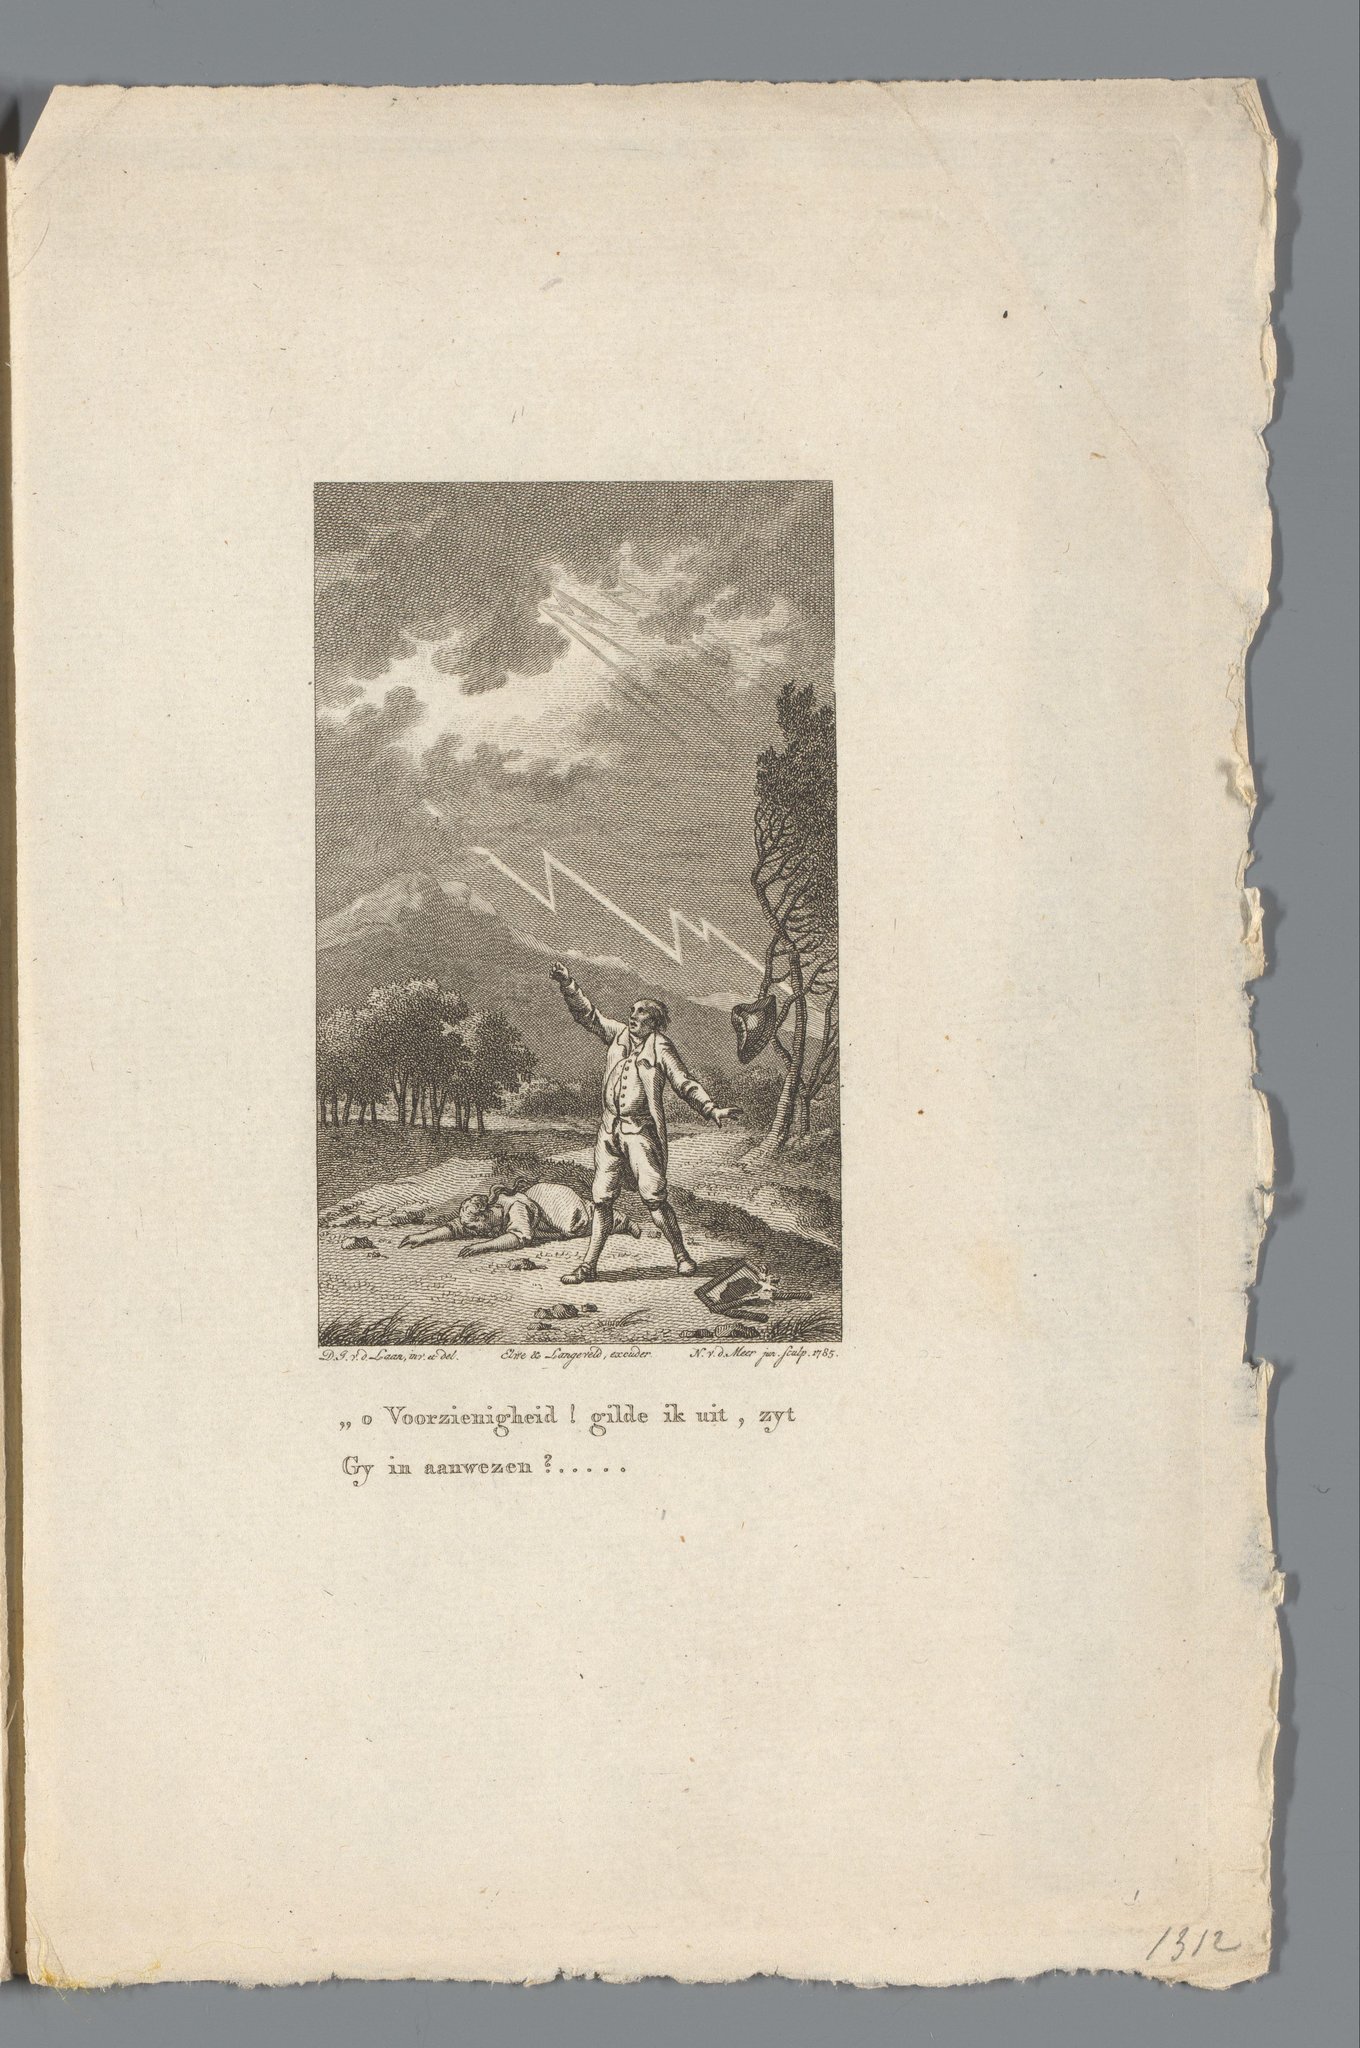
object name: print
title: O Voorzienigheid! gilde ik uit, zyt Gy in aanwezen? (...)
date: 1785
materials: paper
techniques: etching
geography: amsterdam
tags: arm raised, with fist, accidents with lightning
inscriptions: collector's mark: Lugt 2228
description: Een vader balt zijn vuist naar de hemel, nadat zijn dochter door de bliksem is getroffen. Zijn hoed waait van zijn hoofd.